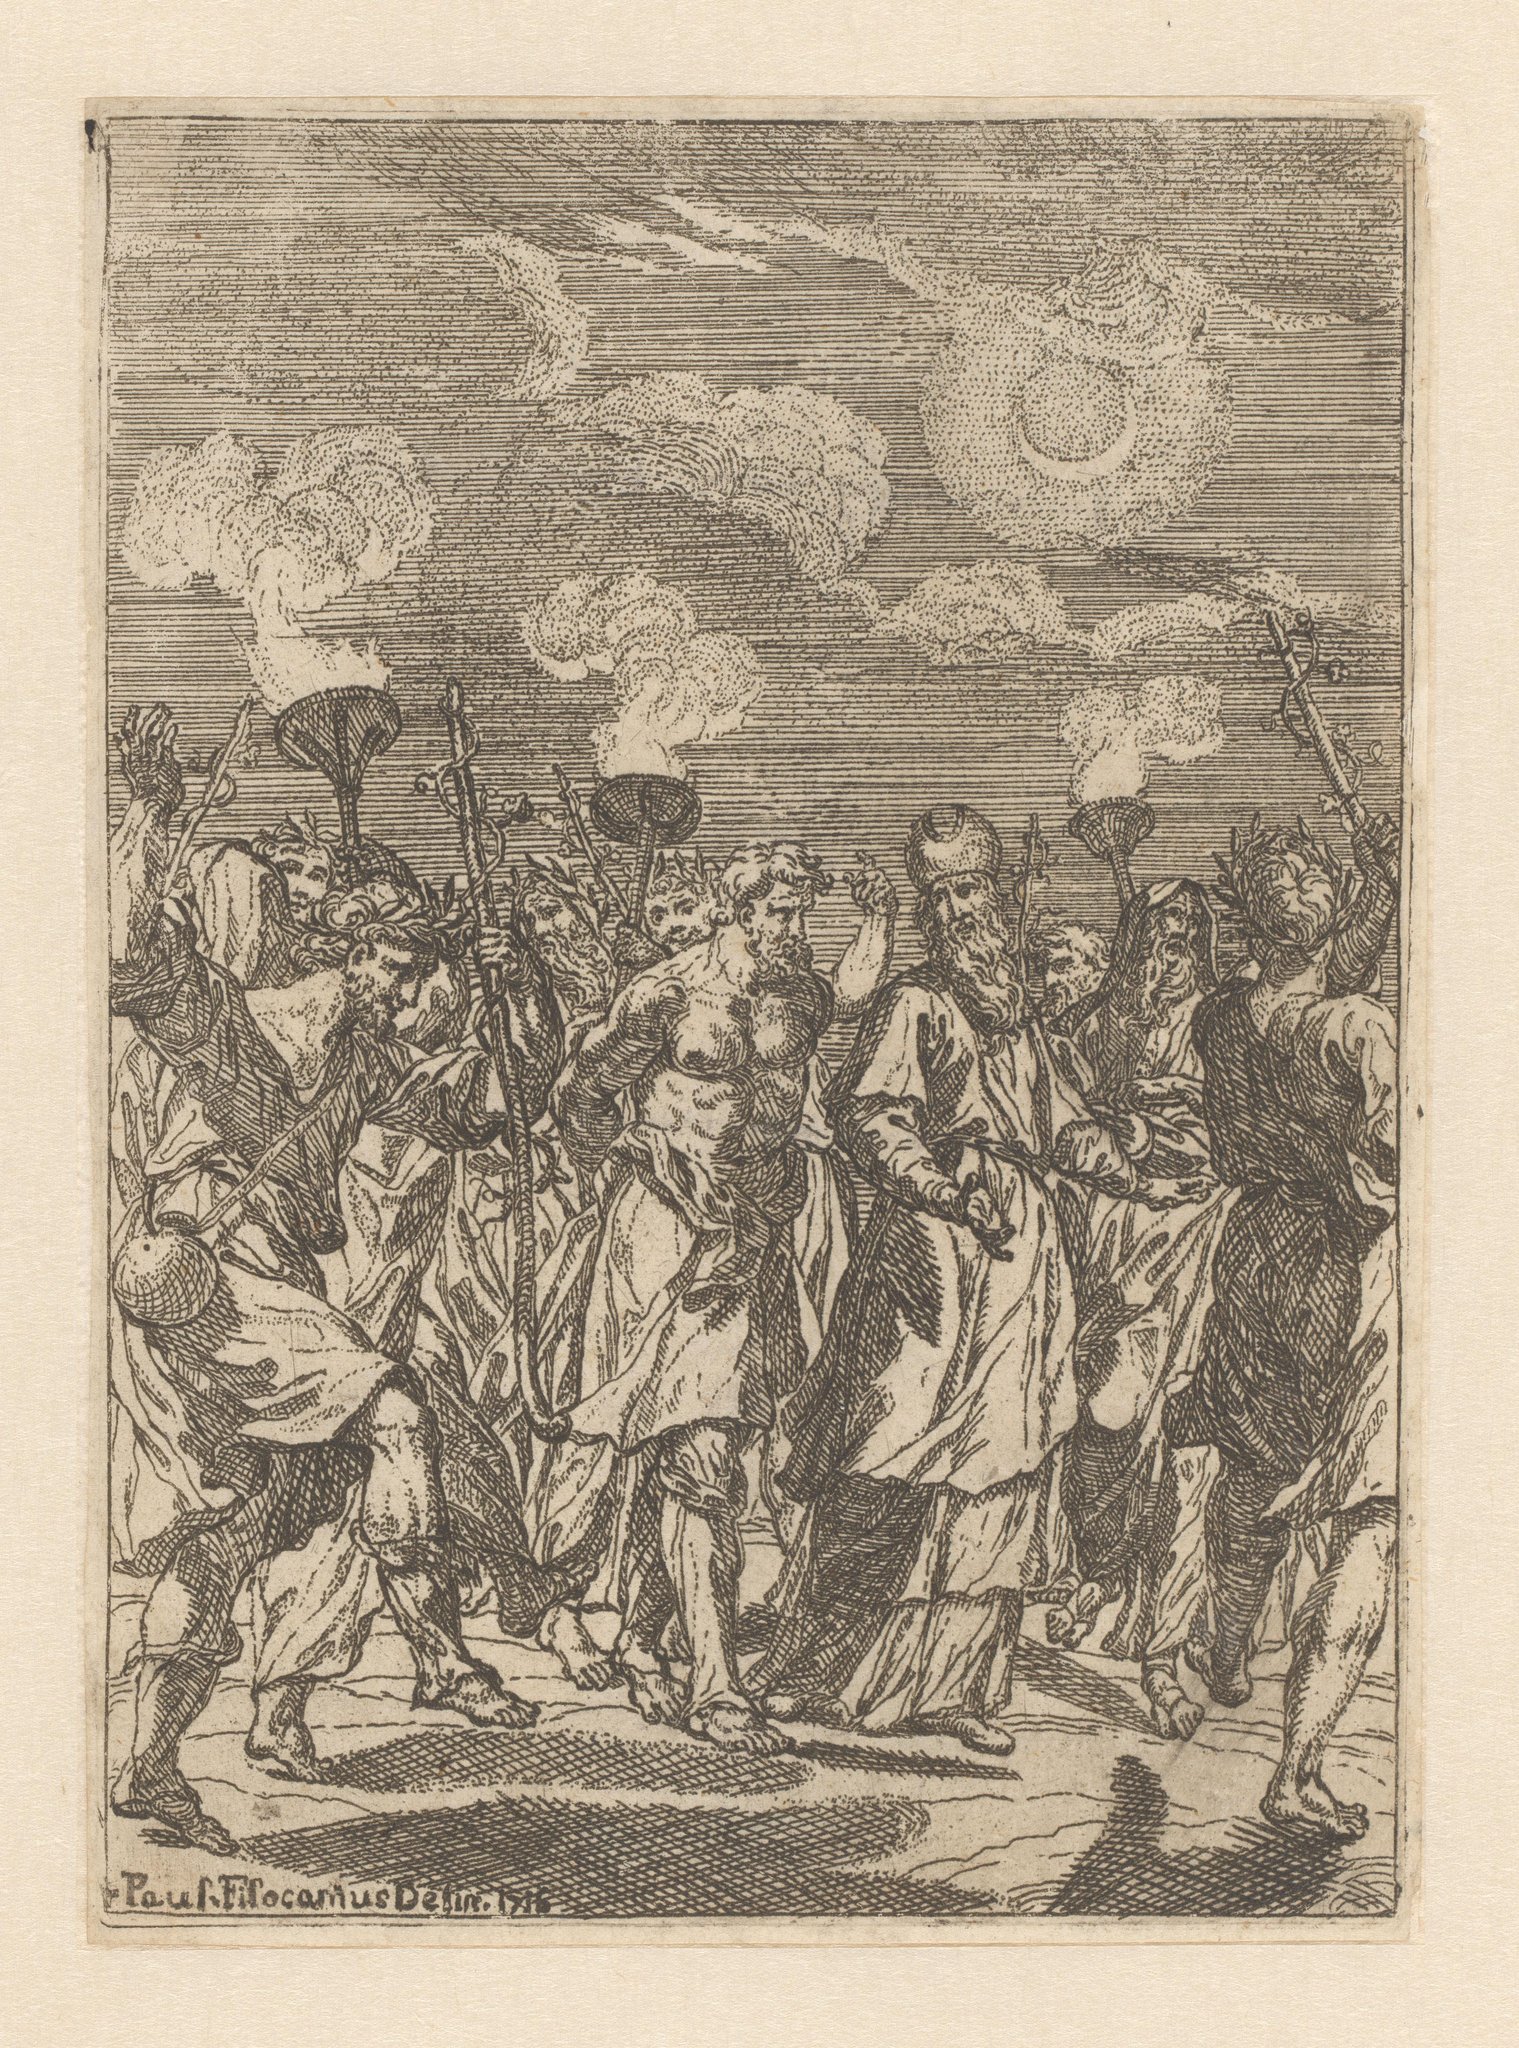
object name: print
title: Fakkeloptocht met een meegevoerde gevangene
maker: paolo filocamo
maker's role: print maker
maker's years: -1743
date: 1716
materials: paper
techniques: etching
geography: messina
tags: torch, conqueror triumphing, triumphal entry of victor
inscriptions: collector's mark: Lugt 2228, collector's mark: Lugt 2760